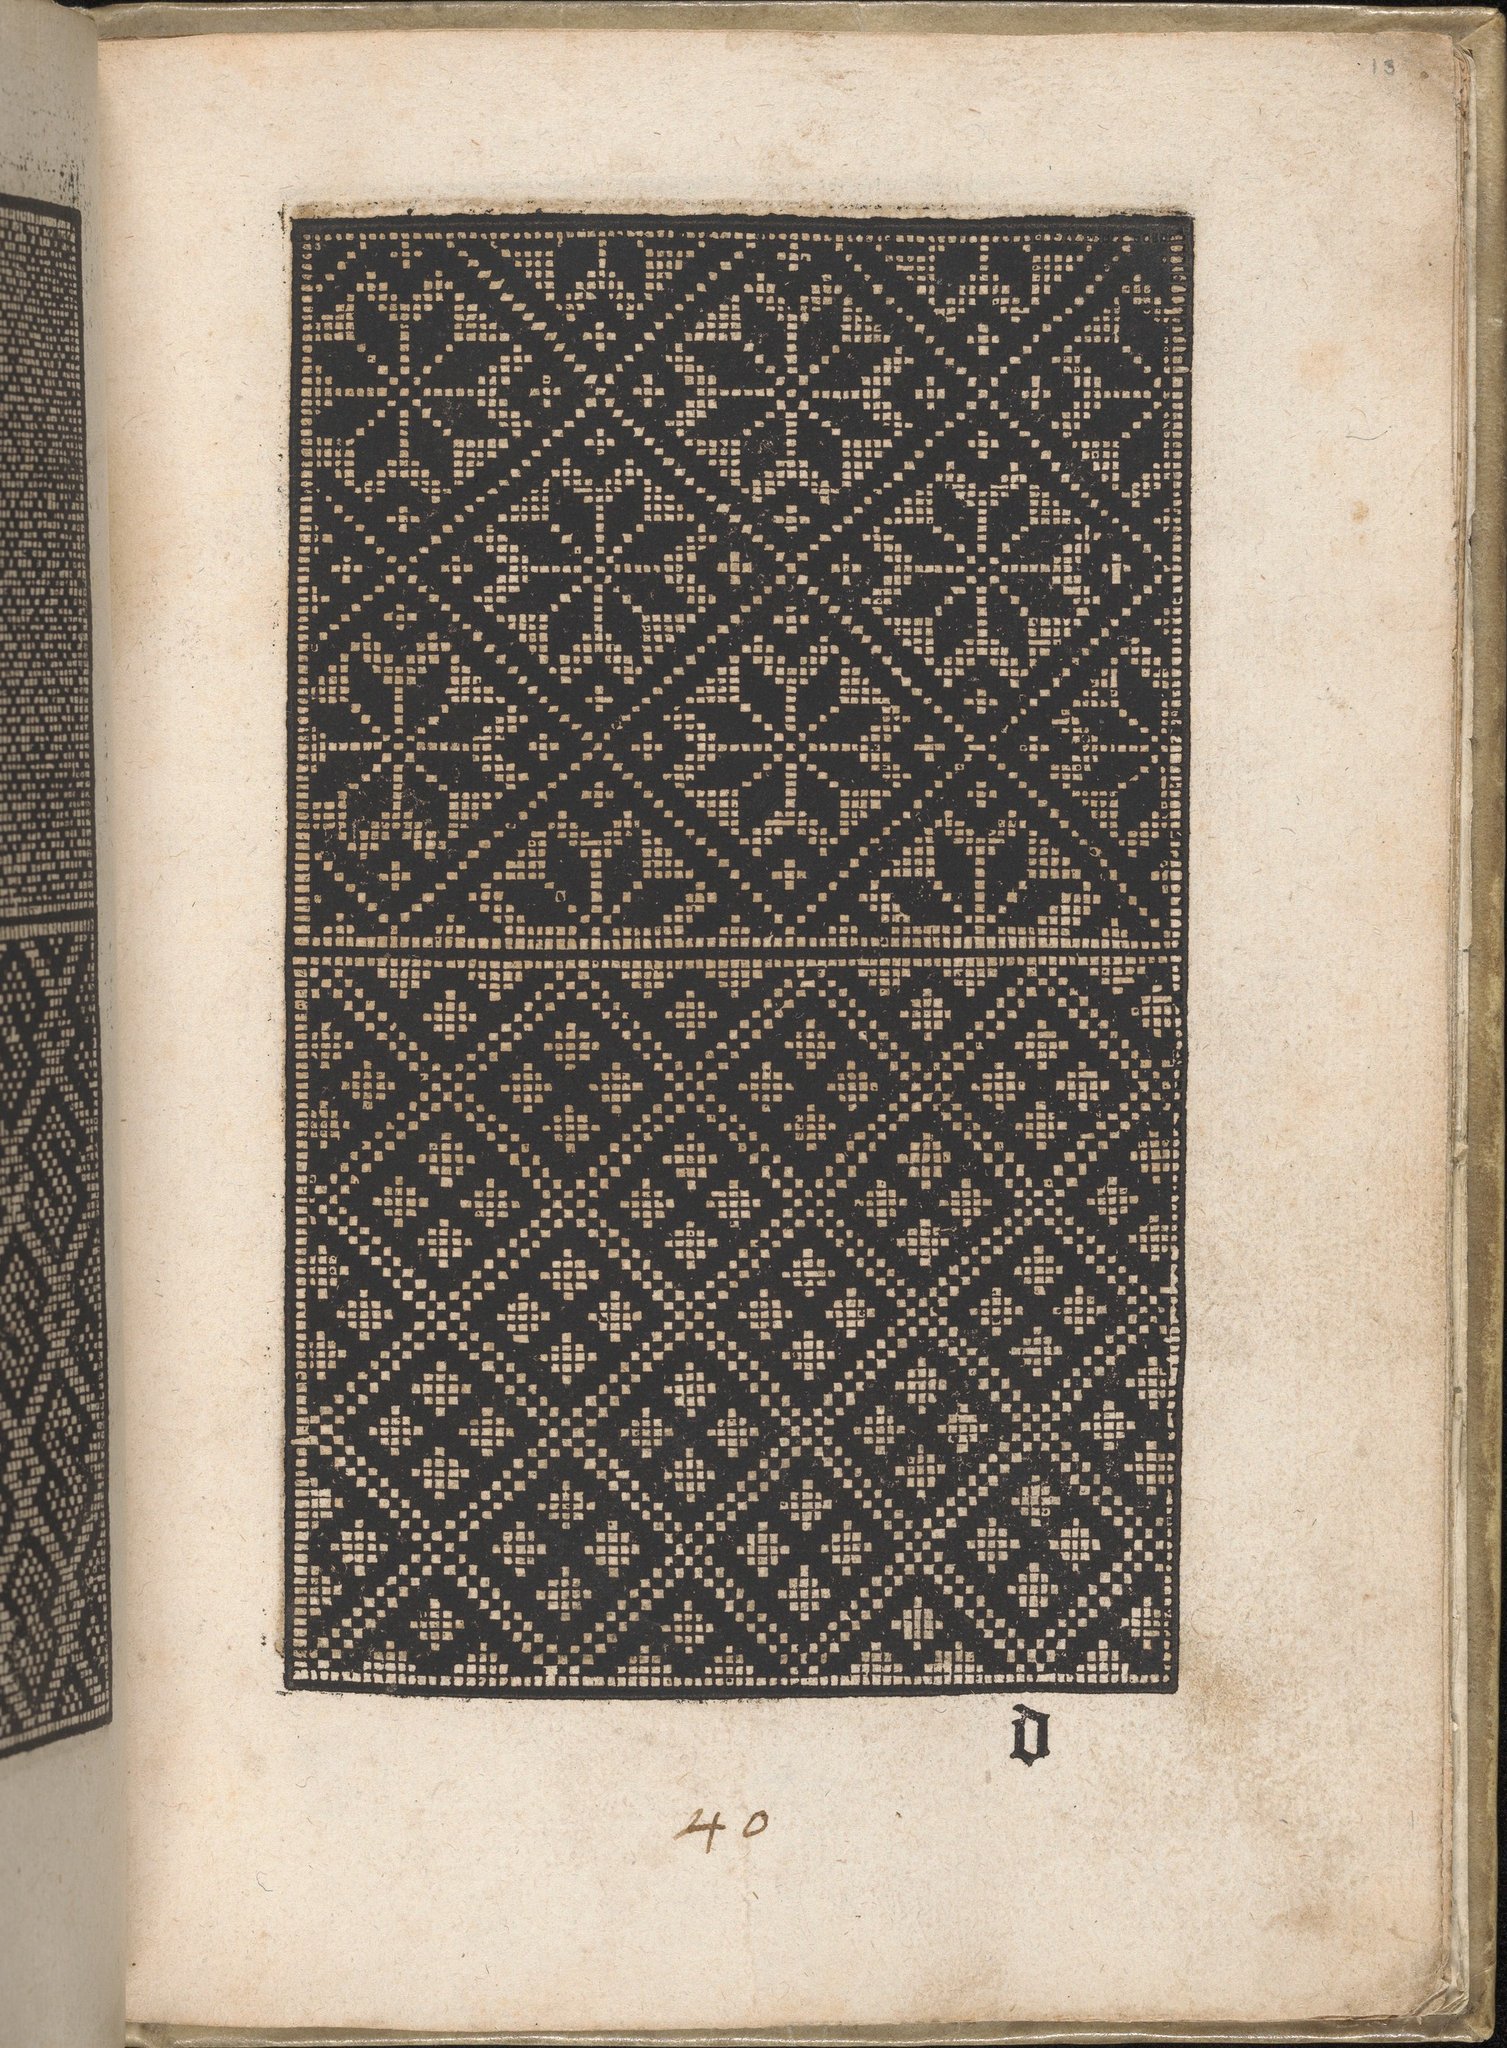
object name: book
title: Page 14r, from "Eyn New Kunstlichboich"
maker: peter quentel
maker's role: publisher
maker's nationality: german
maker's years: 1500-1550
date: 1529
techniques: woodcut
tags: ornament